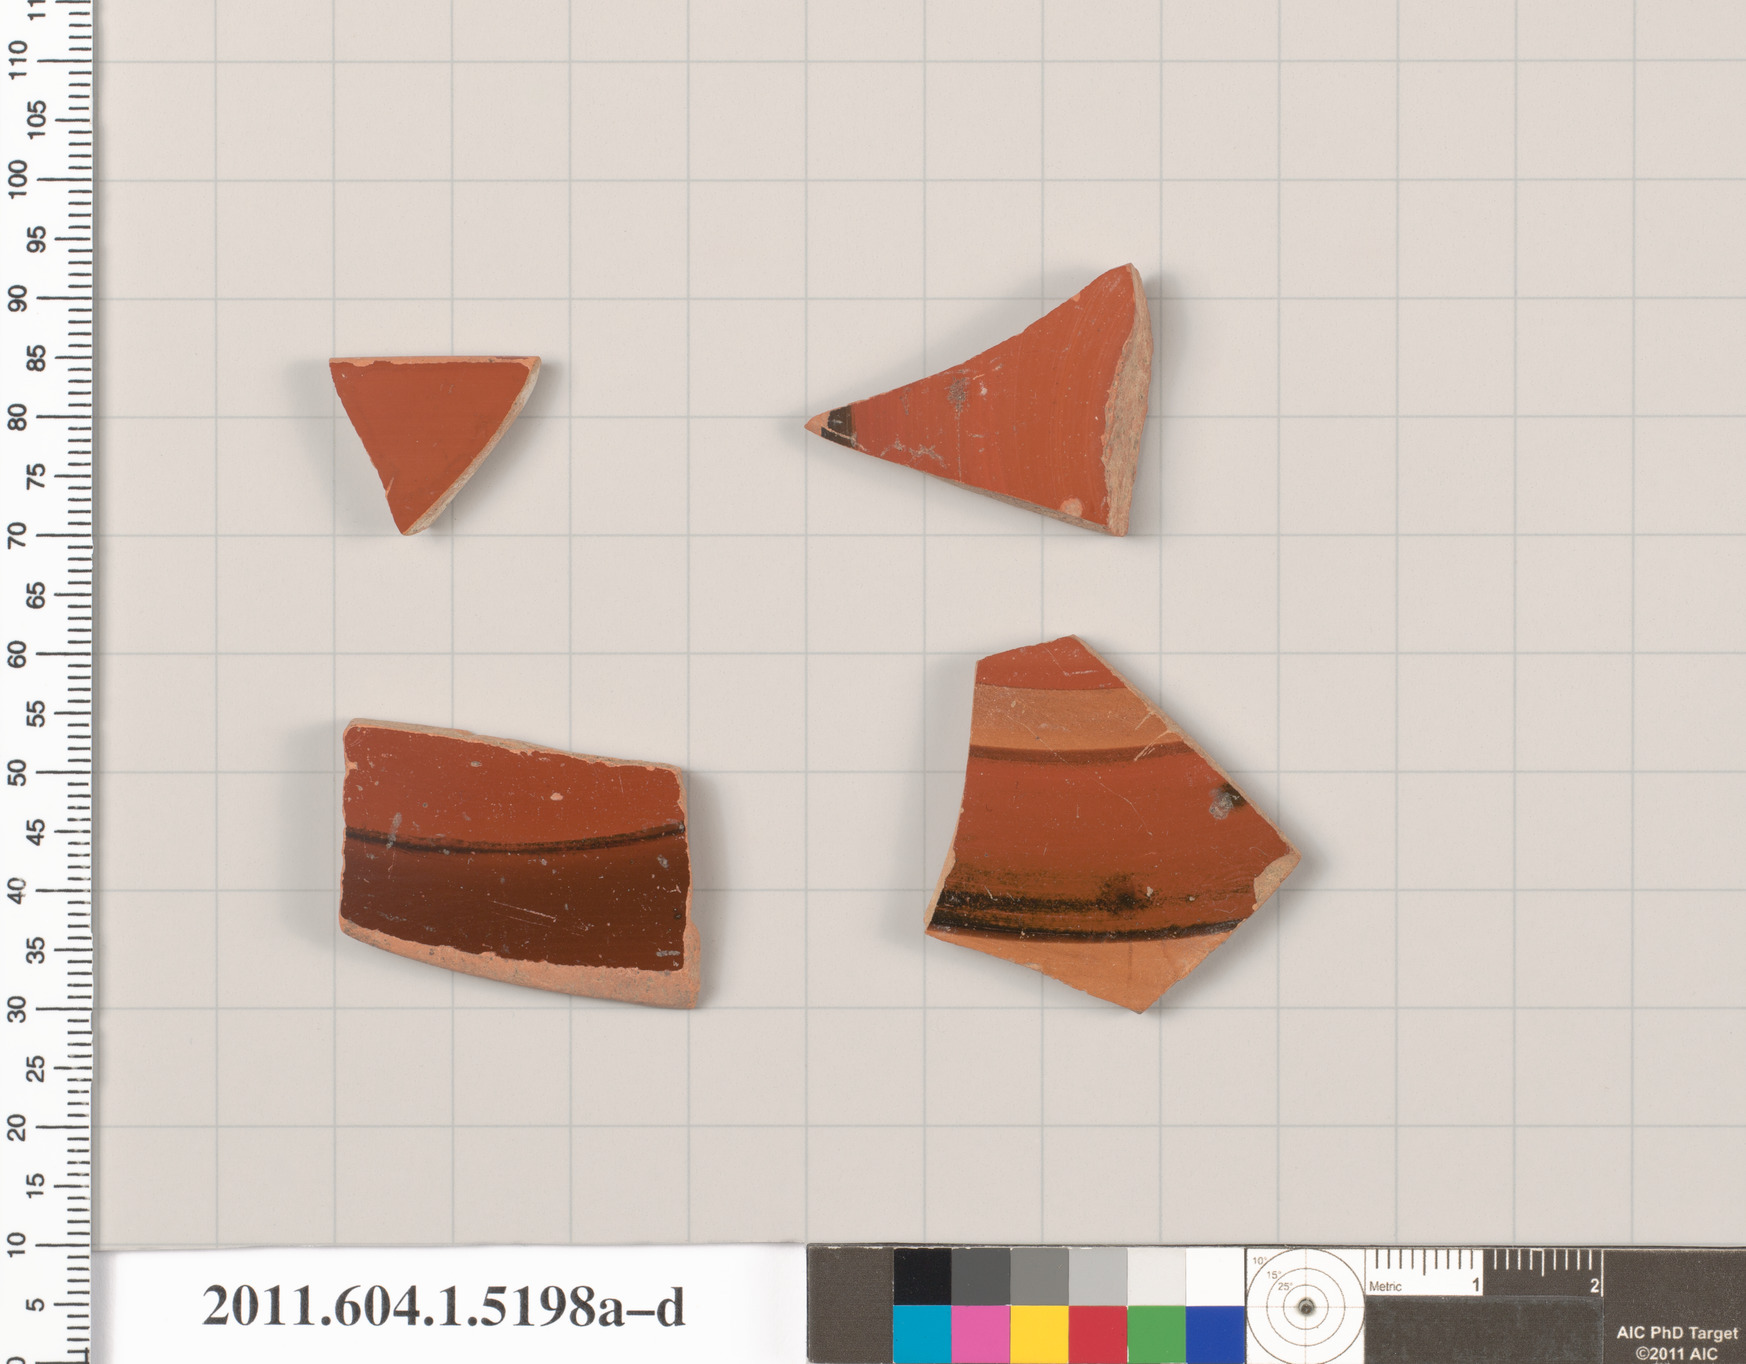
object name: kylix fragment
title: Terracotta fragments of kylikes (drinking cups)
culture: greek, attic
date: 500-451 BCE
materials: terracotta